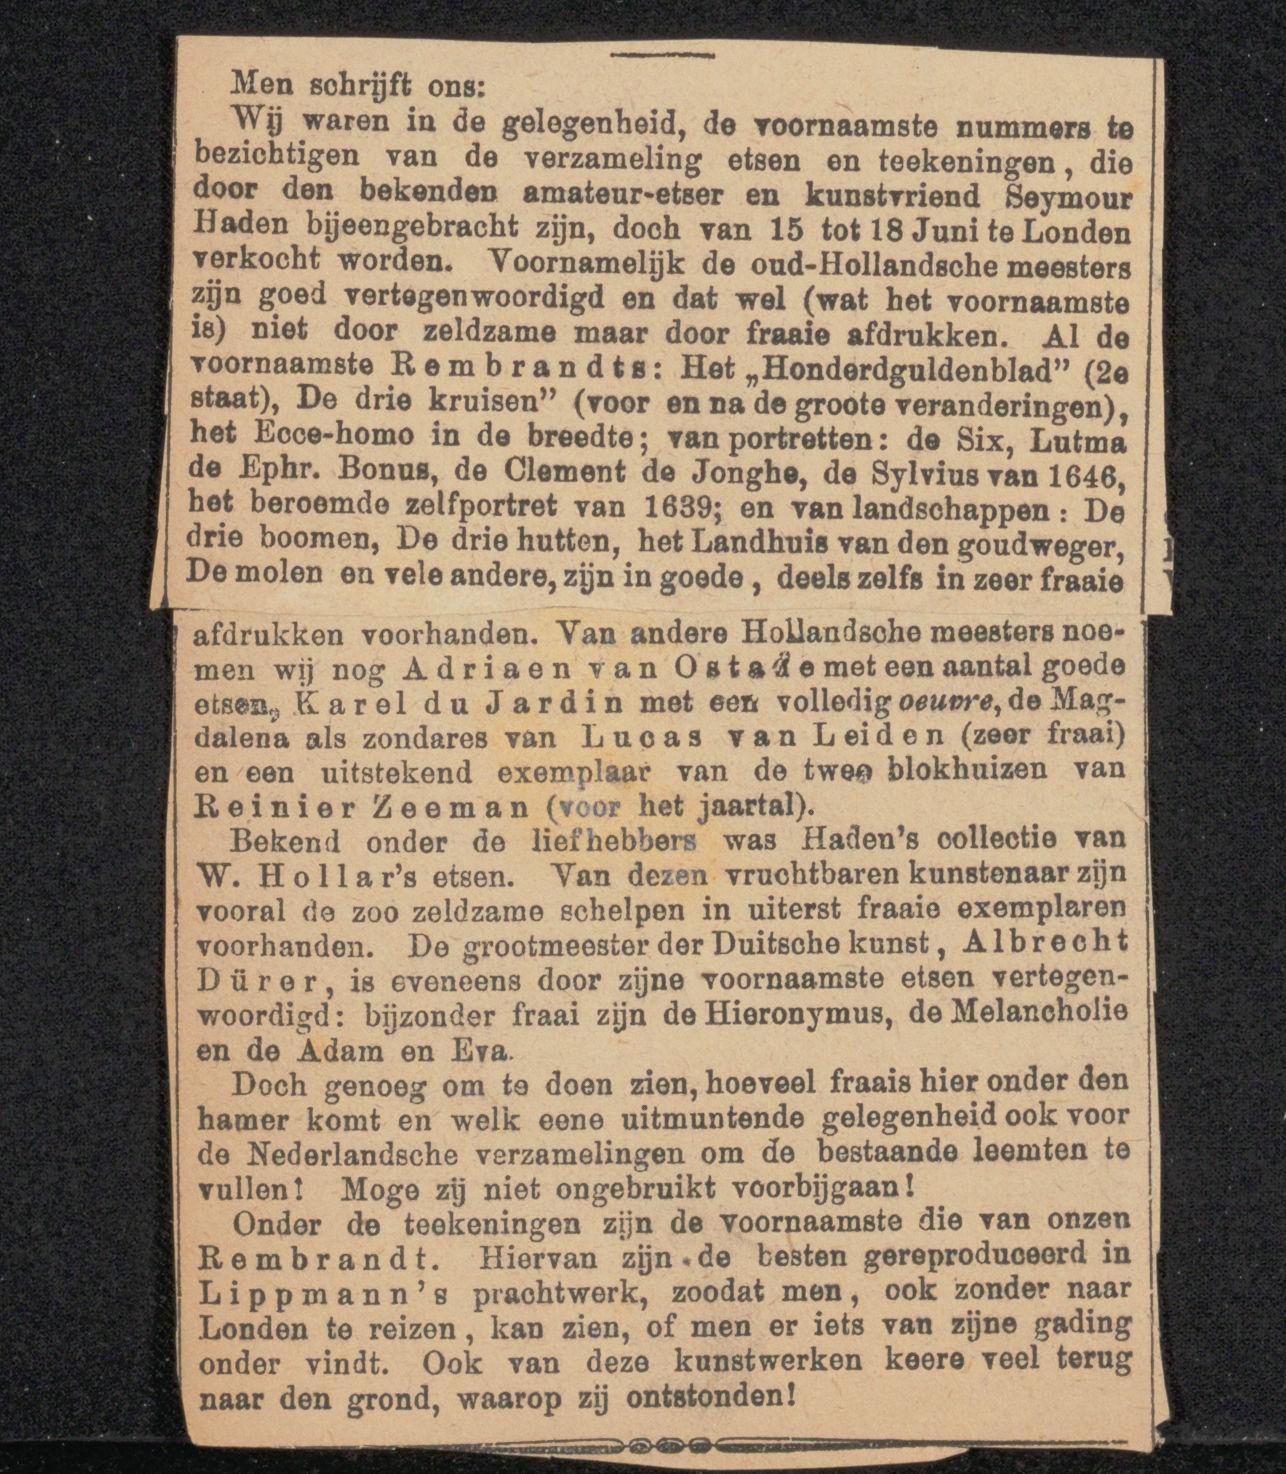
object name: newspaper clipping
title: Krantenknipsel uit archief Jan Veth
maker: Anonymous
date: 1874-1925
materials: paper, ink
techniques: printing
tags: dordrecht, painter, print maker, draughtsman, designer, jan veth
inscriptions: collector's mark: ‘RPK’